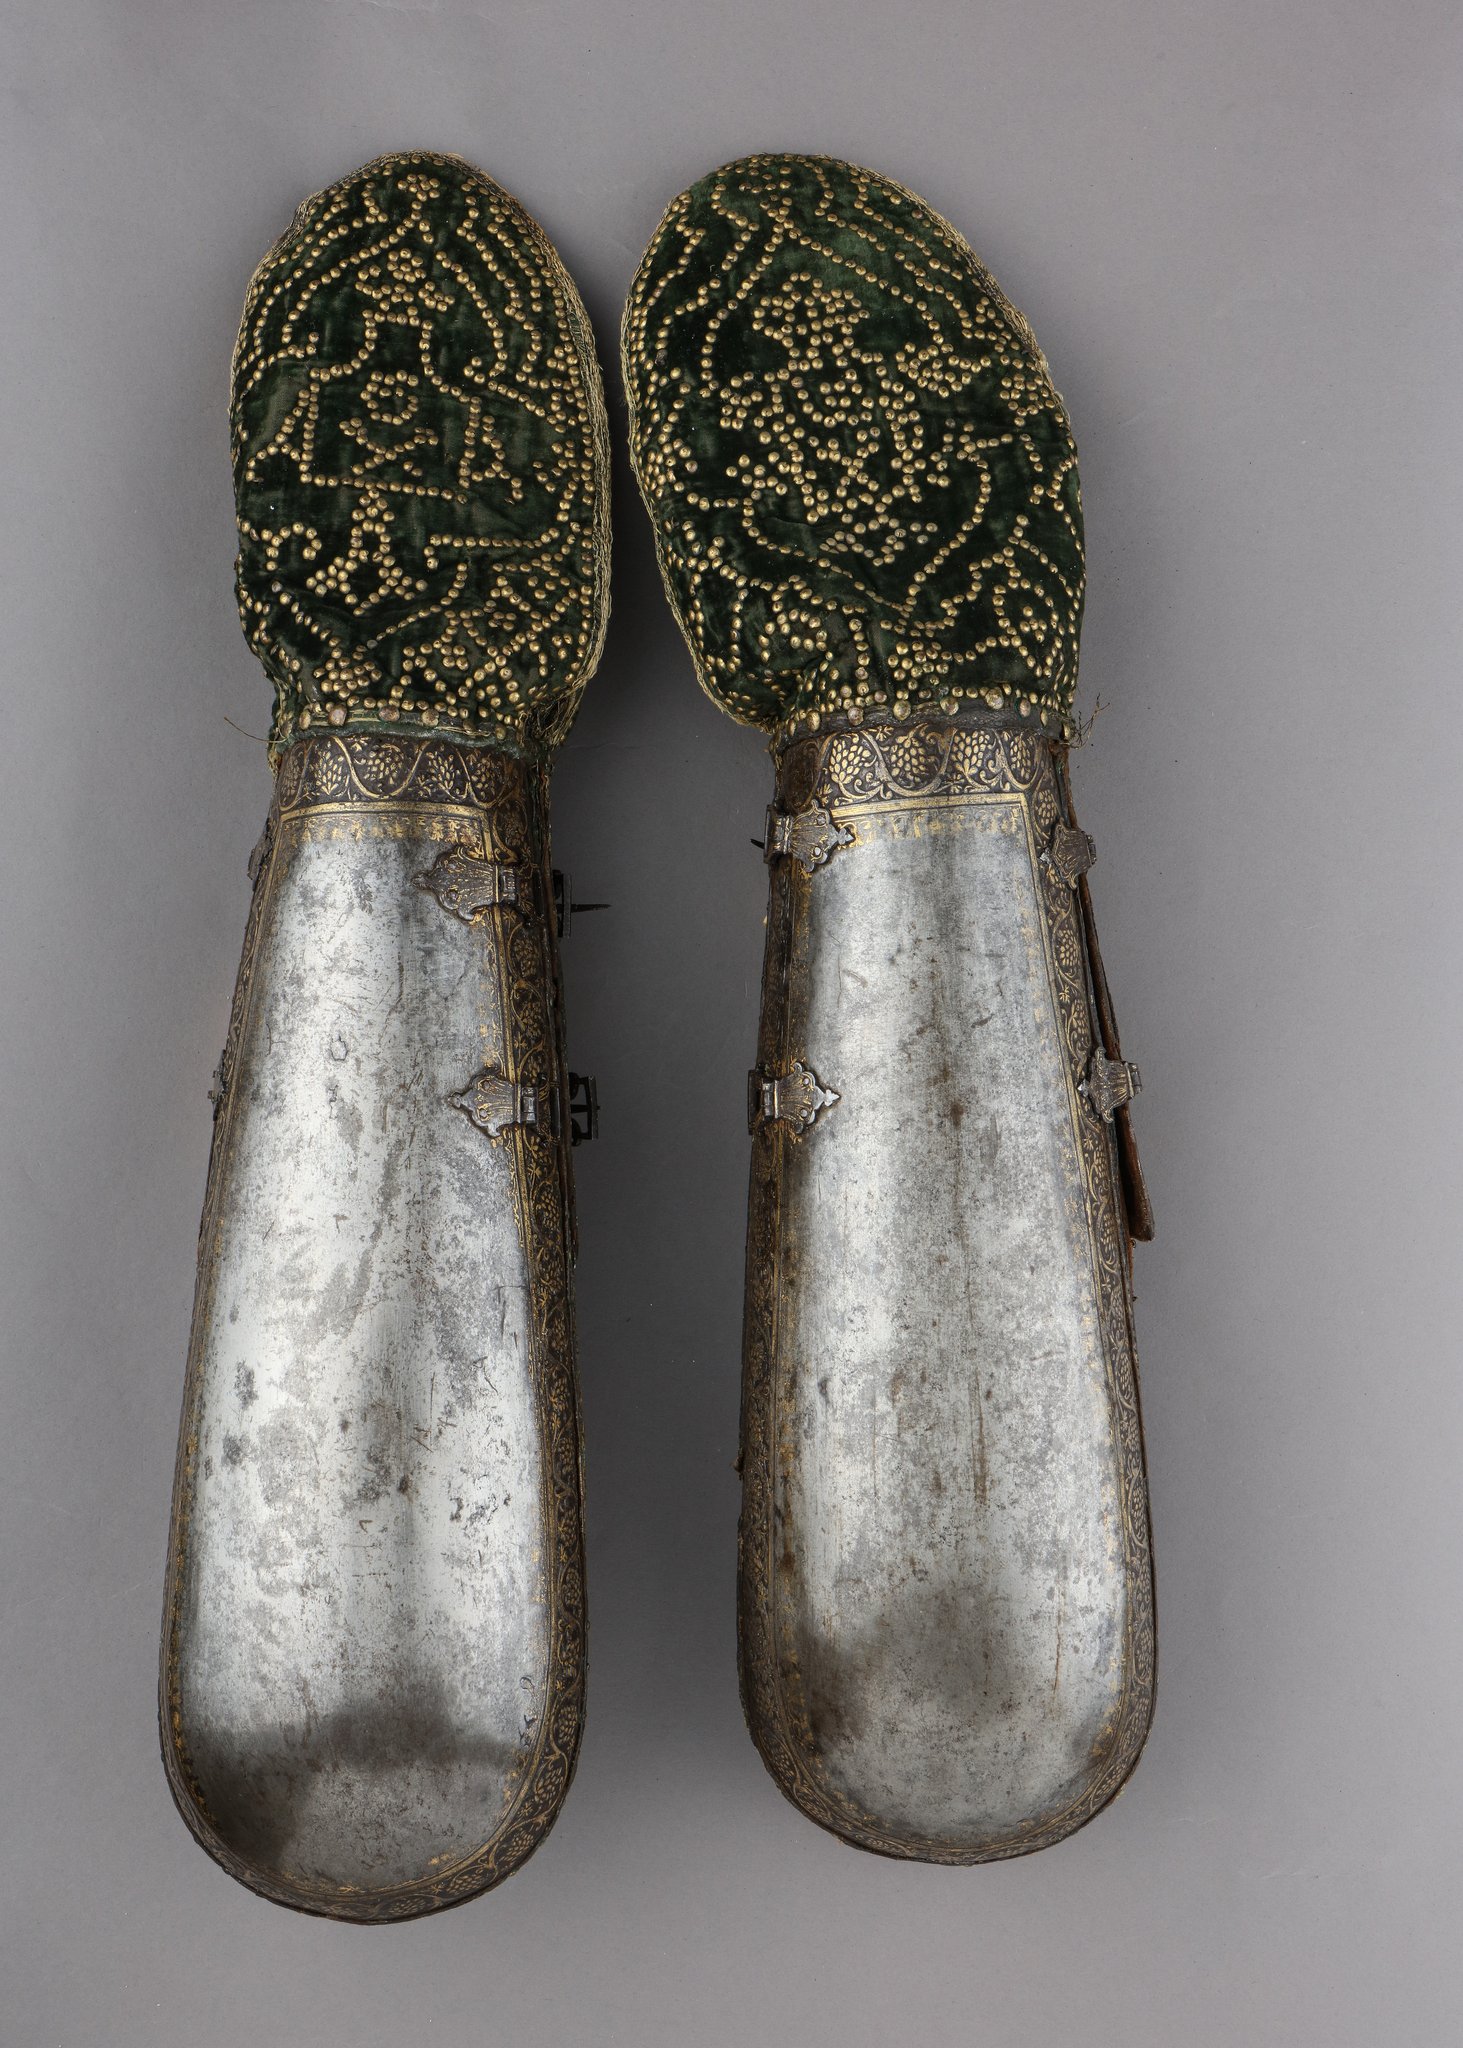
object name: pair of arm guard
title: Pair of Arm Guards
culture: indian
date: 1701-1800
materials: copper alloy, gold, steel, textile, velvet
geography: india